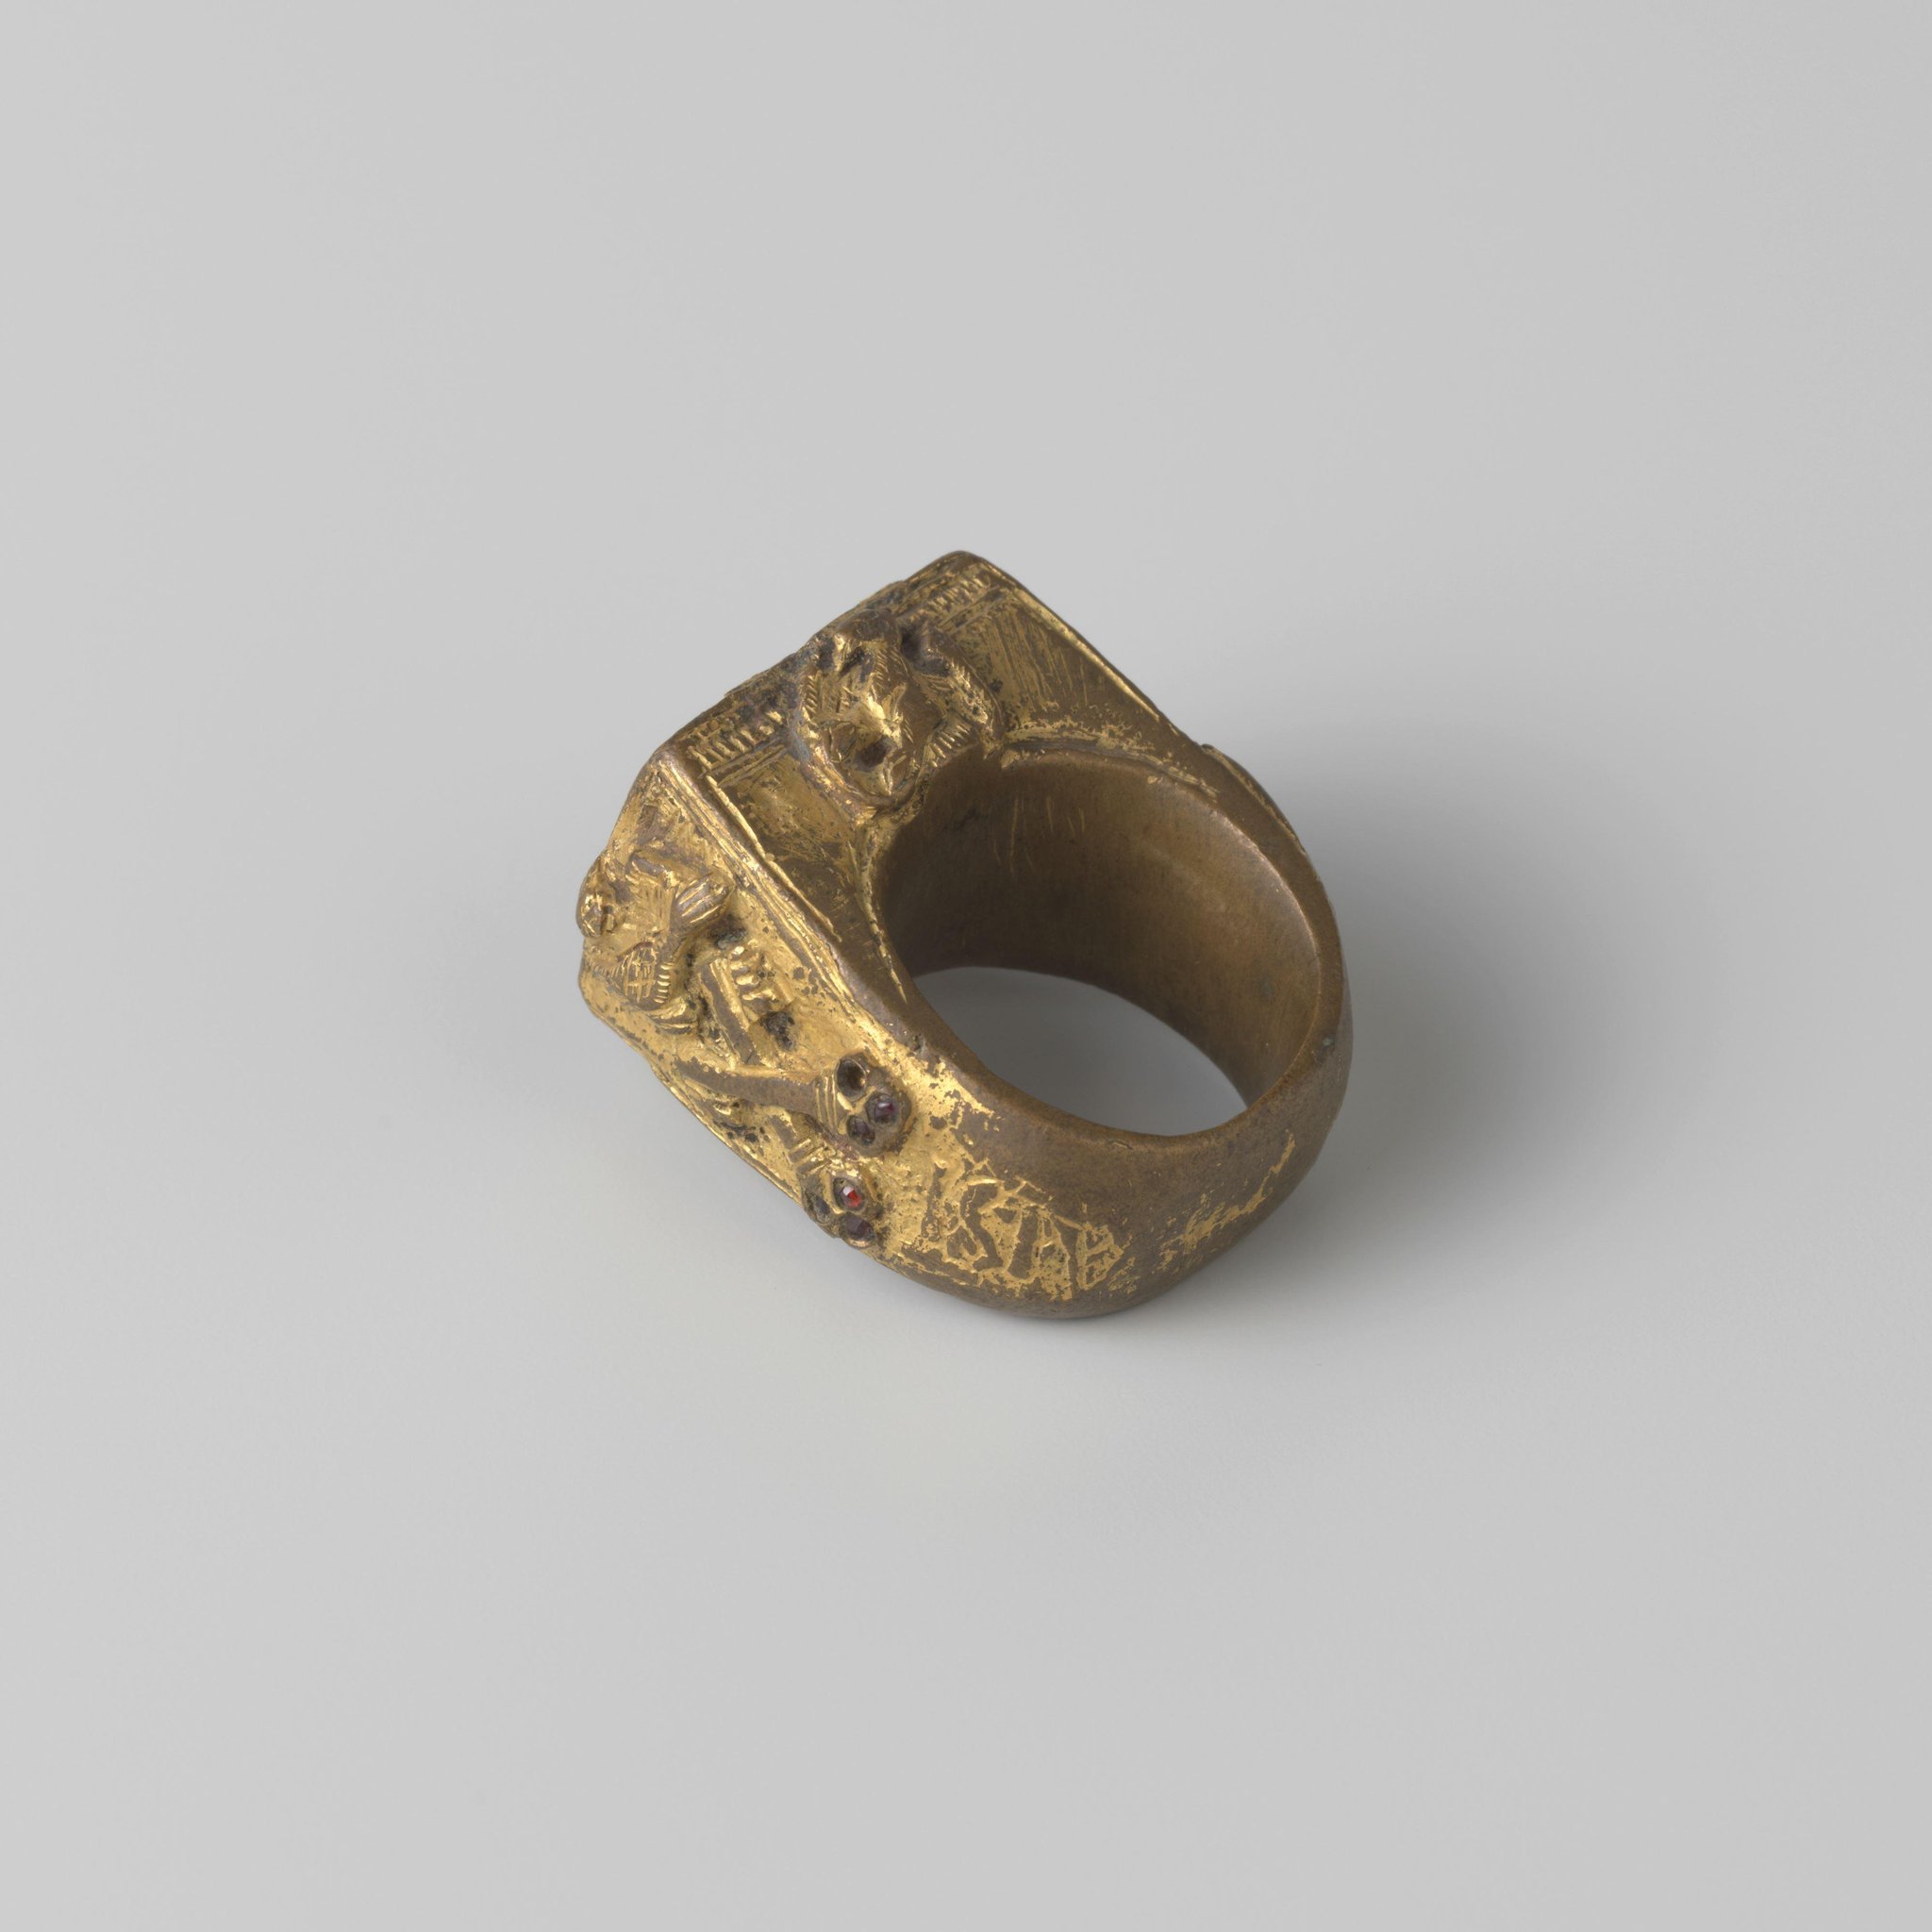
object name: bishop's ring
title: Bisschopsring met de symbolen van de vier evangelisten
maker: Anonymous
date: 1300-1500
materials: brass, bronze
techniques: casting, metalworking, gilding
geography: italy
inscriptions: inscription: ‘PA . . . IS’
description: De gegoten en bijgeciseleerde ring is bovenaan rechthoekig en aan de vier zijden versierd met de symbolen van de vier evangelisten: de engel (Johannes), het gevleugelde rund (Lucas), de adelaar (Mattheus) en de leeuw (Marcus). Op de versmalling aan weerszijden zijn een adelaar en twee gekruist geplaatste sleutels weergegeven, die ieder met drie rode steentjes zijn versierd. Op de ronde kant van de ring is een opschrift aangebracht, dat grotendeels afgesleten is: PA . . . IS (?). De rechthoekige (edel)steen, die in de ring was gevat, ontbreekt.